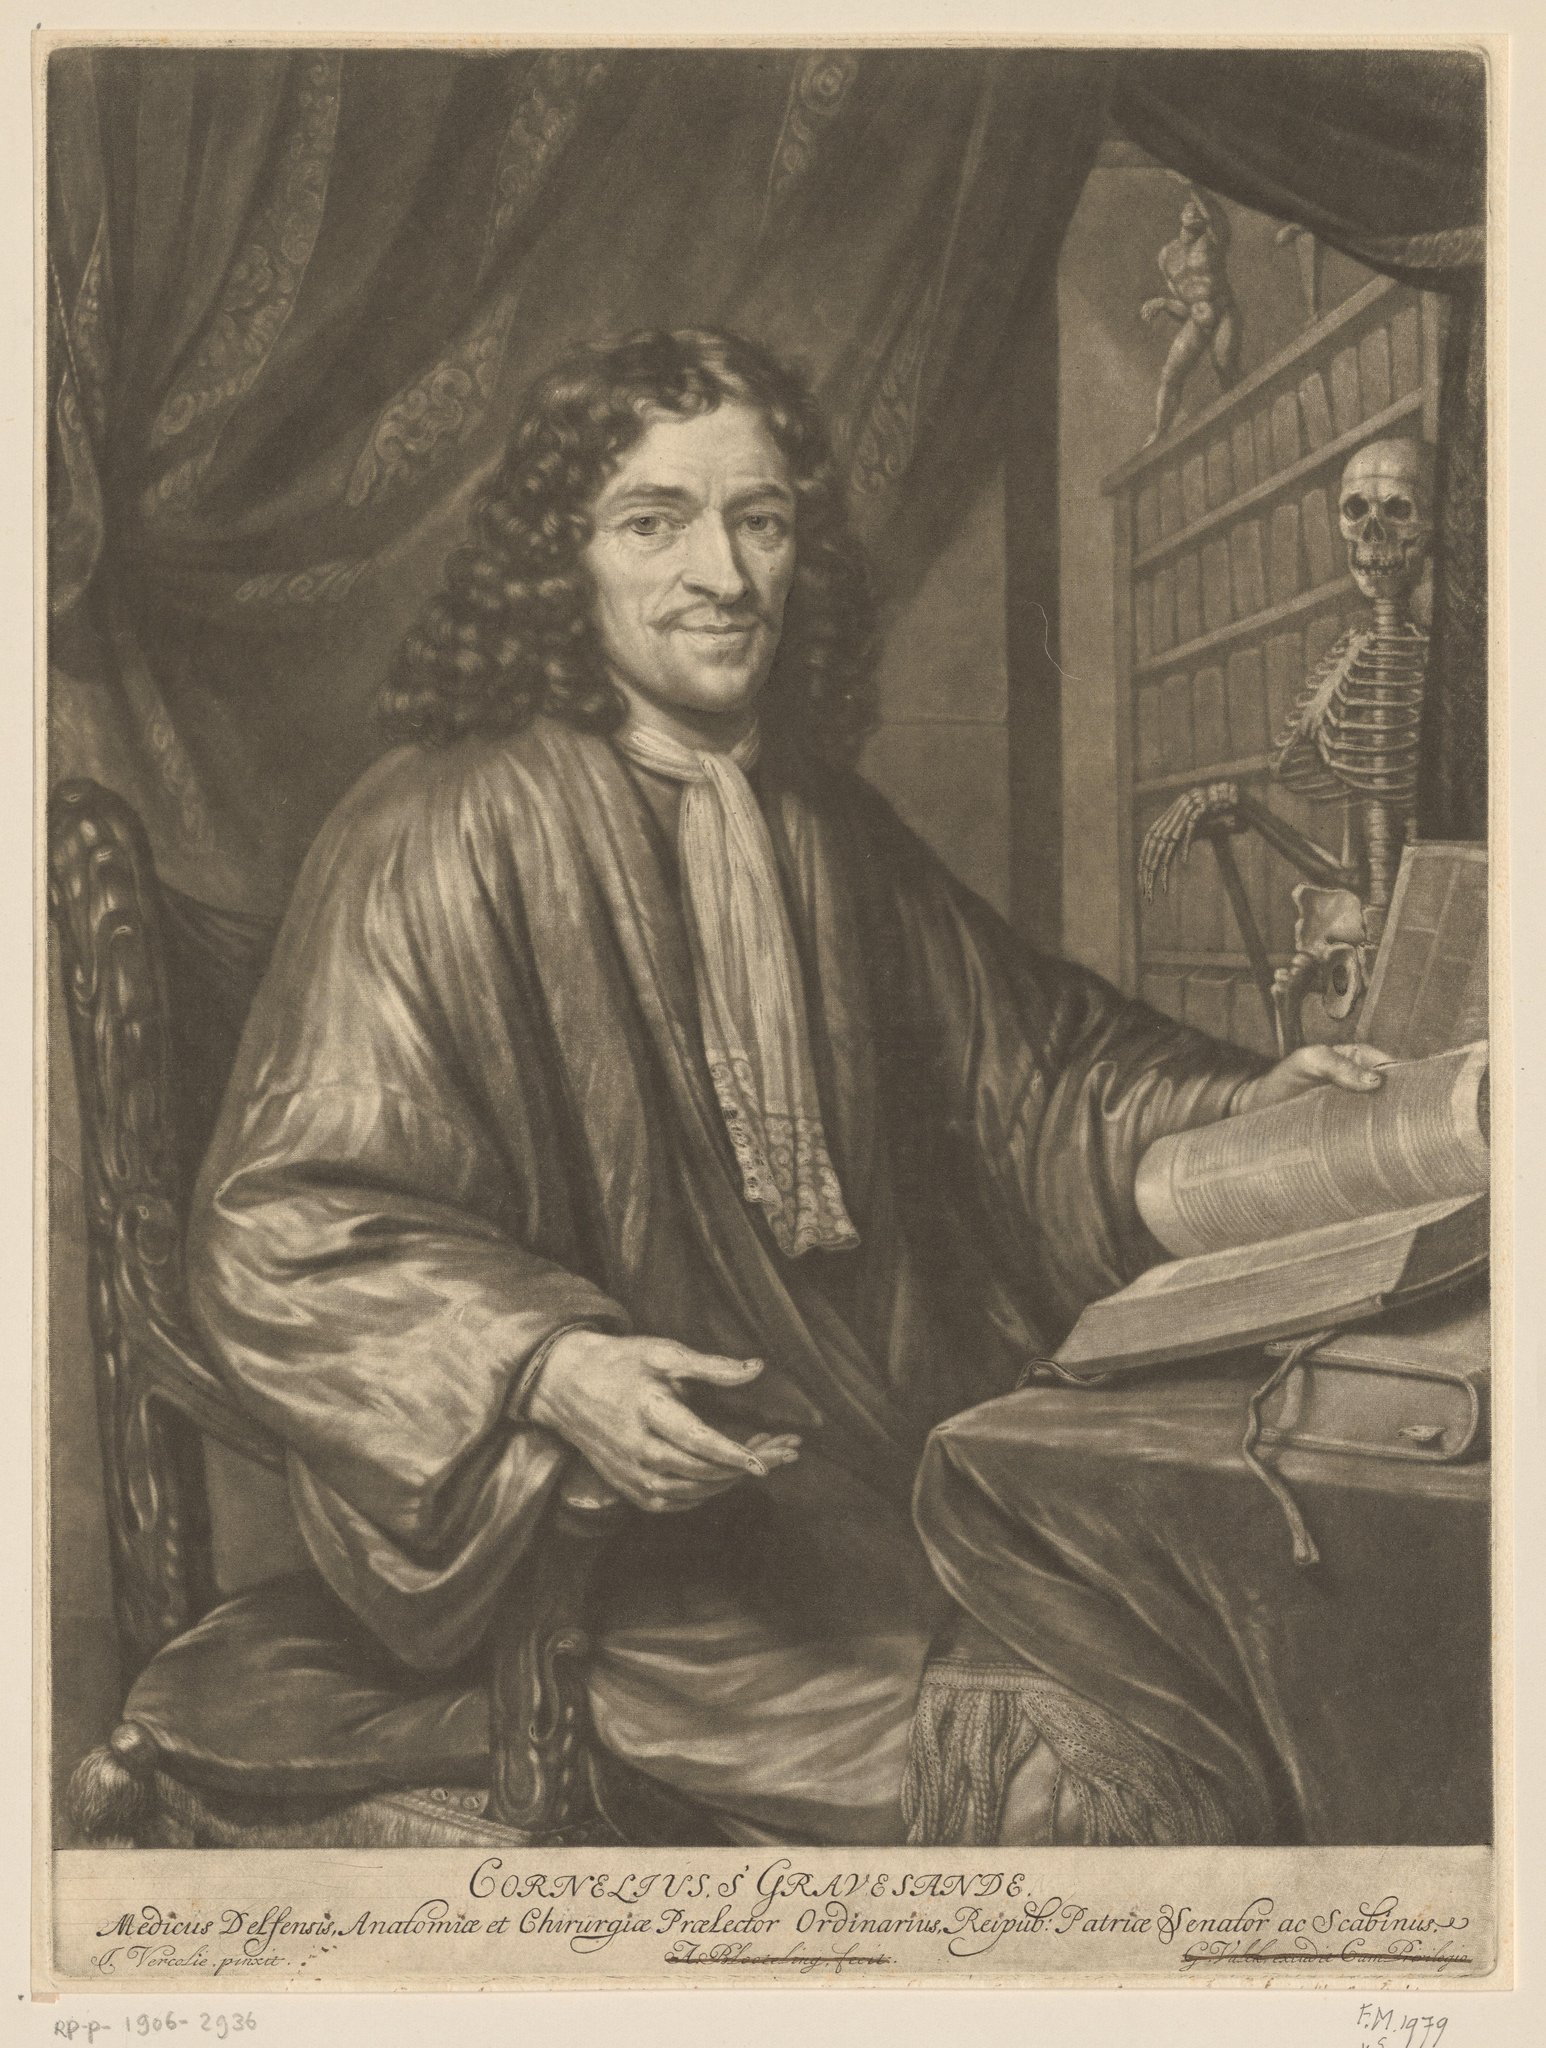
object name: print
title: Portret van Cornelius 's-Gravesande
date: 1660-1690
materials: paper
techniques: mezzotint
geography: amsterdam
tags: delft, writing-table, writing-desk, historical persons, aspects of science in general (+ in workshop, laboratory), (human) skeleton, physician, doctor (+ portrait of scholar, scientist)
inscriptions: collector's mark: Lugt 2228